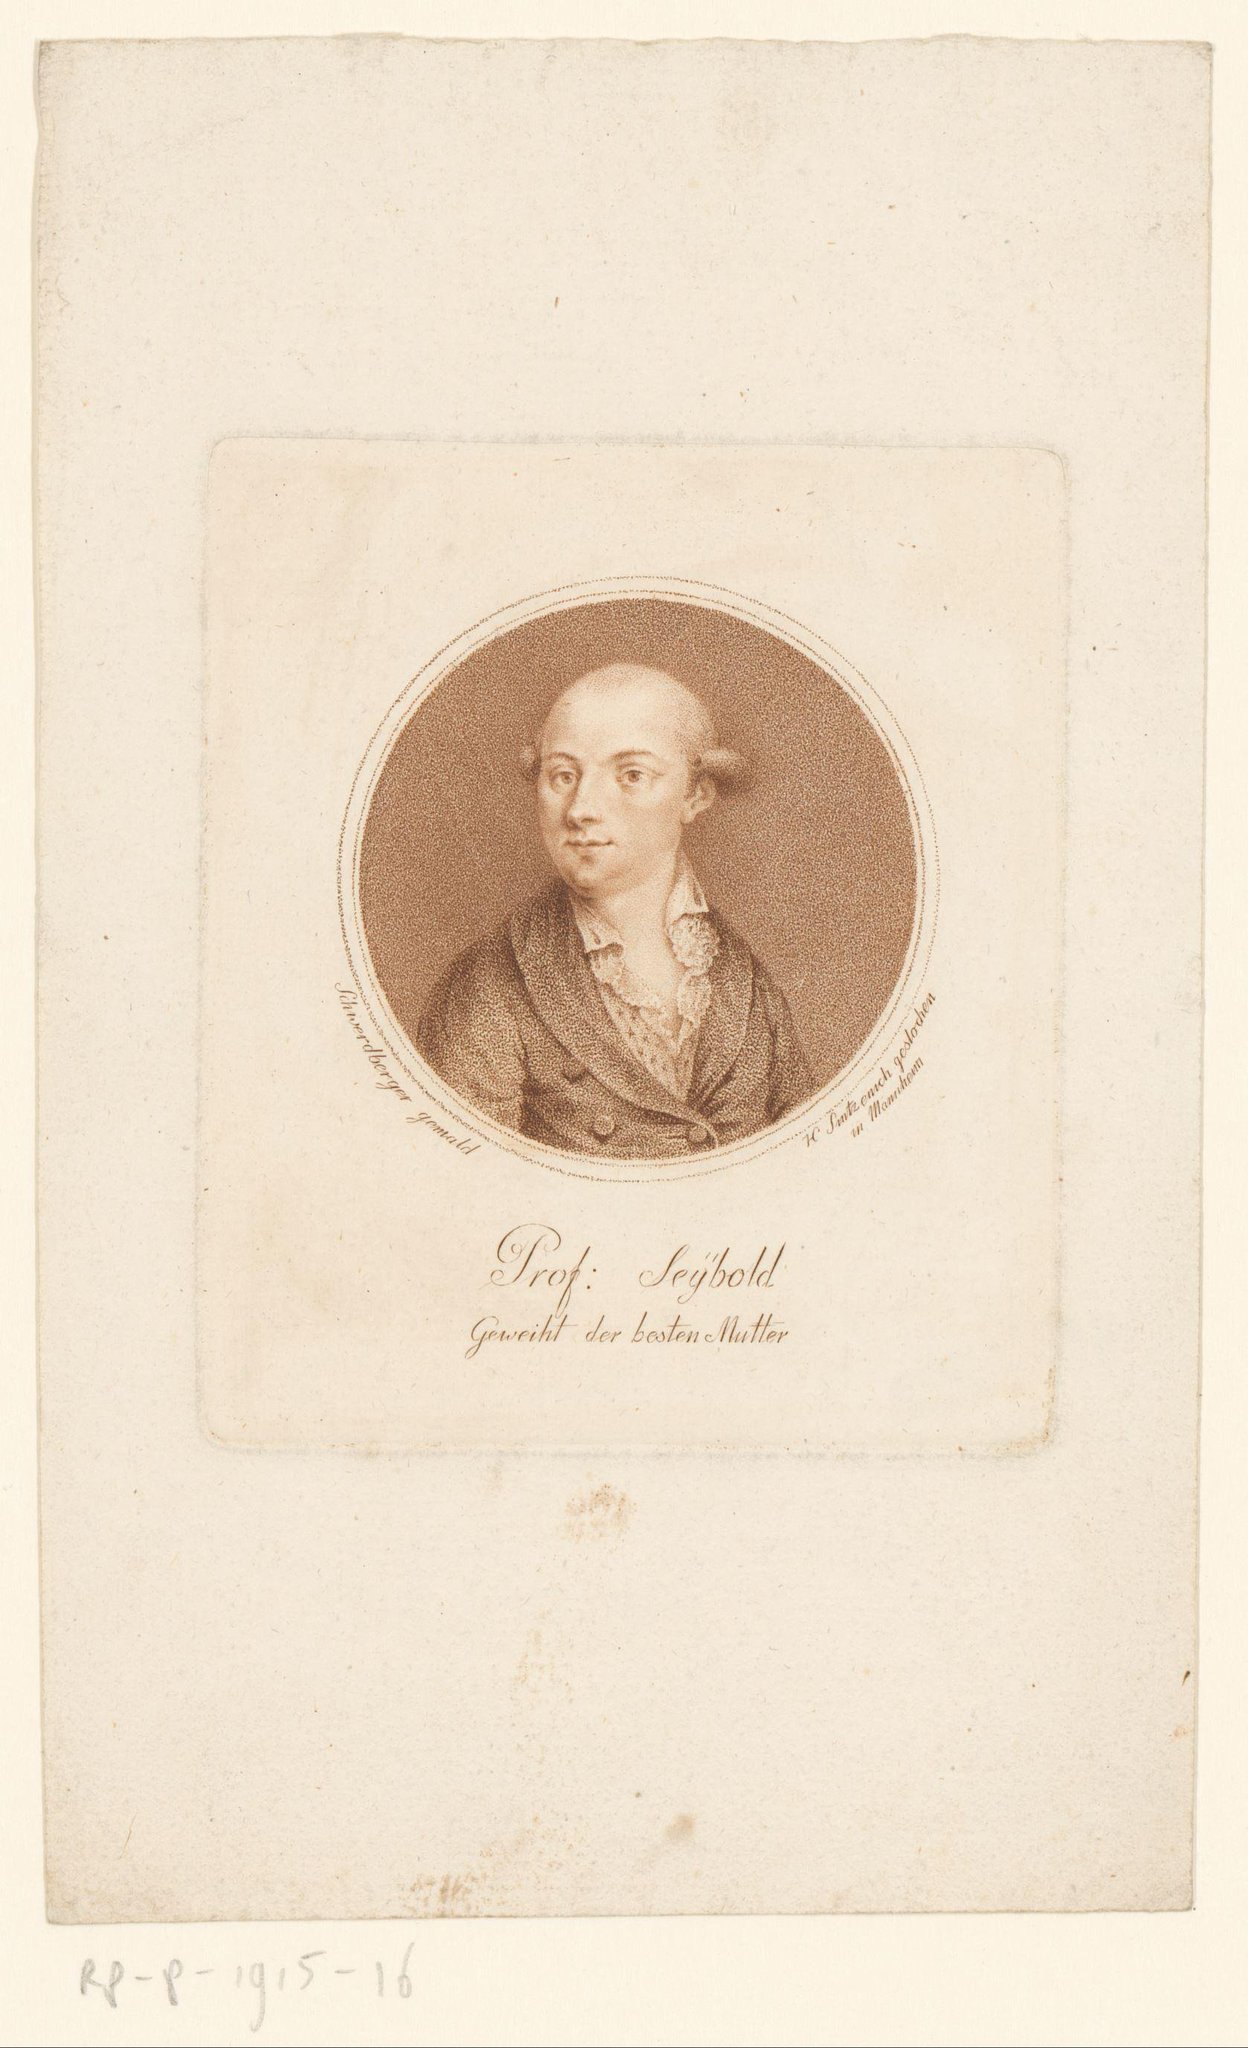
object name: print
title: Portret van David Christoph Seybold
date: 1762-1812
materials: paper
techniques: engraving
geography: mannheim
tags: historical persons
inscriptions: collector's mark: Lugt 2228